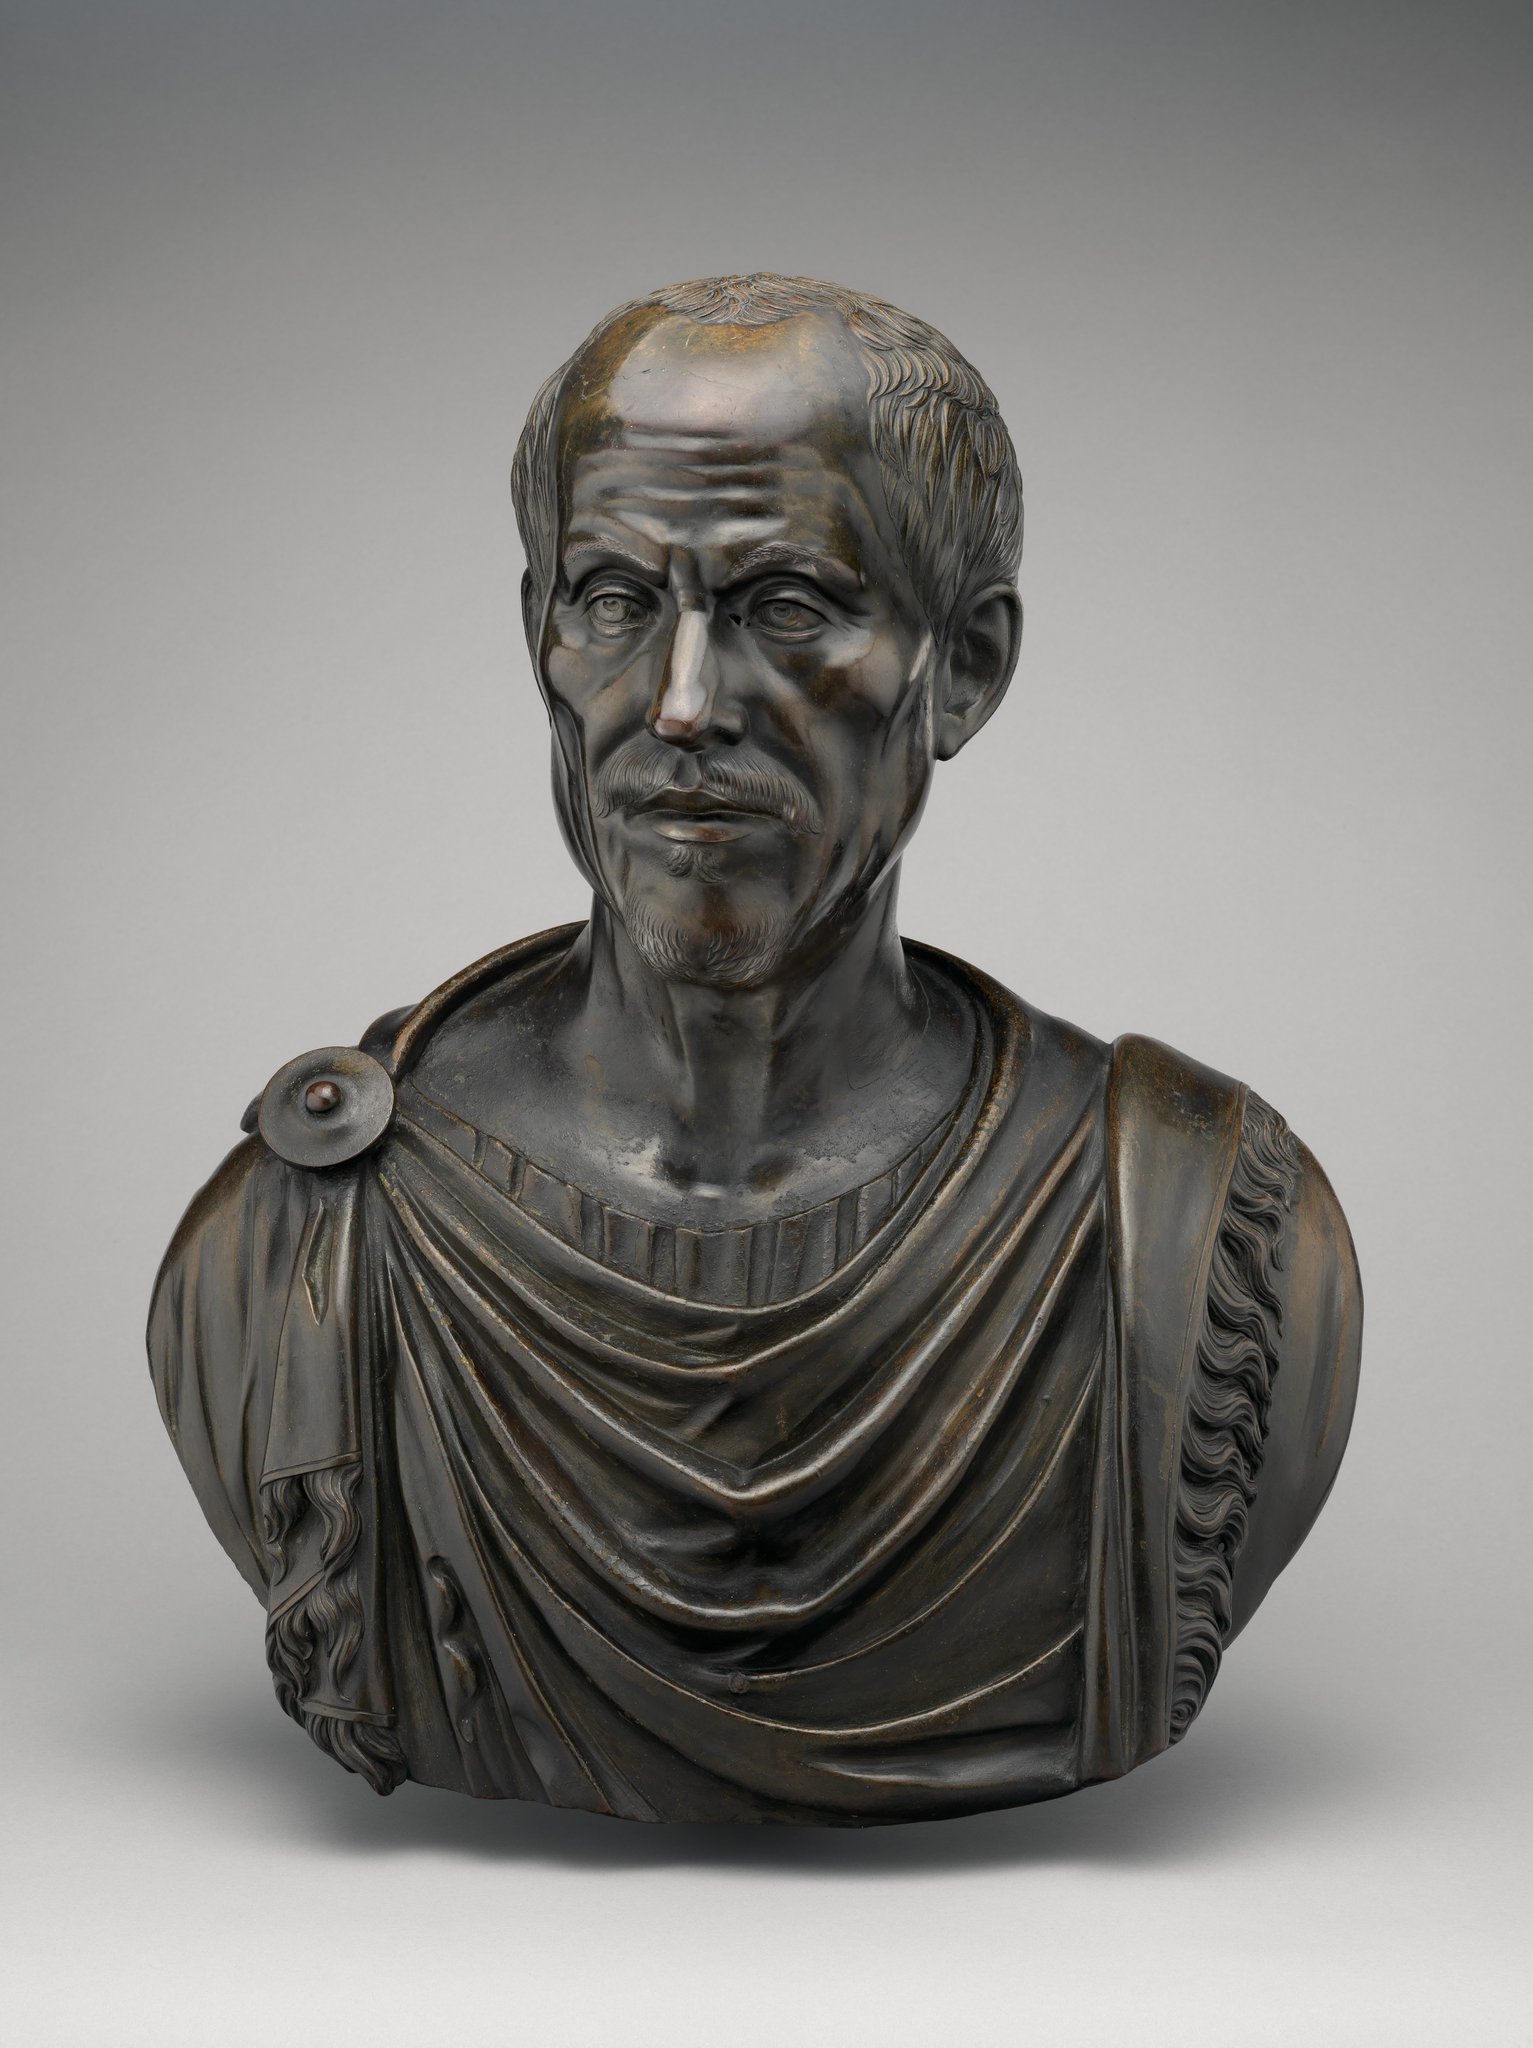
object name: bust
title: Bust of a Roman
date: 1601-1700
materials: bronze, gilt, oil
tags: men,portraits